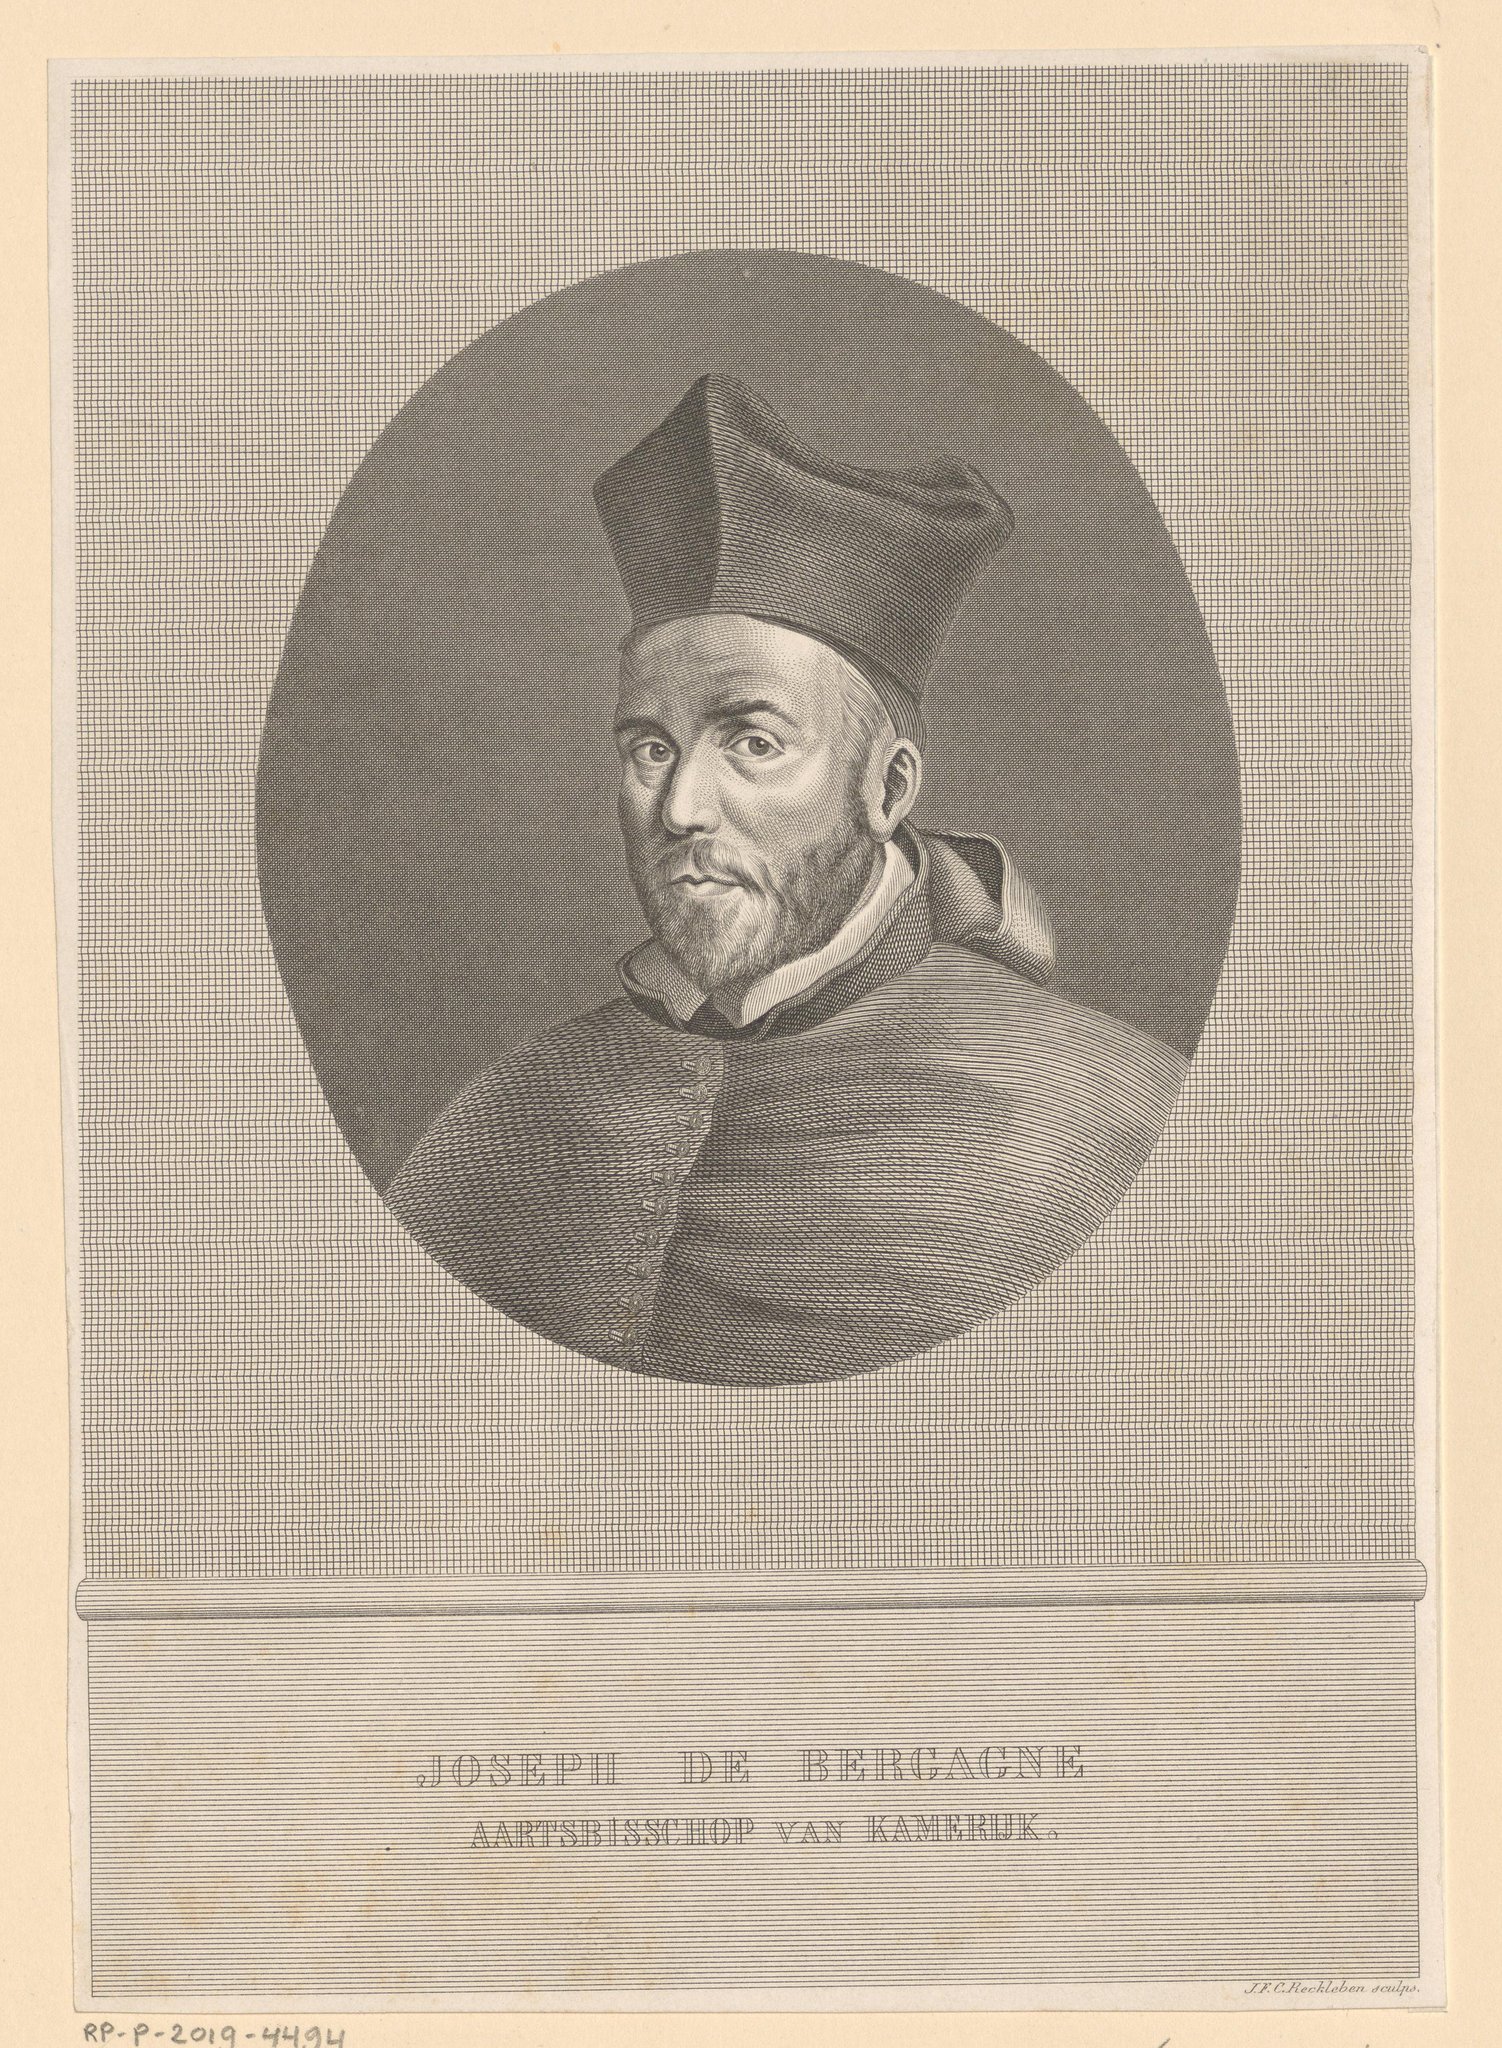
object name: book illustration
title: Portret van Joseph de Bergaigne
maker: jan frederik christiaan reckleben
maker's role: print maker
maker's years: 1819-1879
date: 1868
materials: paper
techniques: engraving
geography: amsterdam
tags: historical persons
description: Prent uit: Arend, Johannes Pieter. Algemeene geschiedenis des vaderlands van de vroegste tijden tot op heden. Amsterdam: C.L. Schleijer & Zoon, 1868, dl. 3, vijfde stuk.